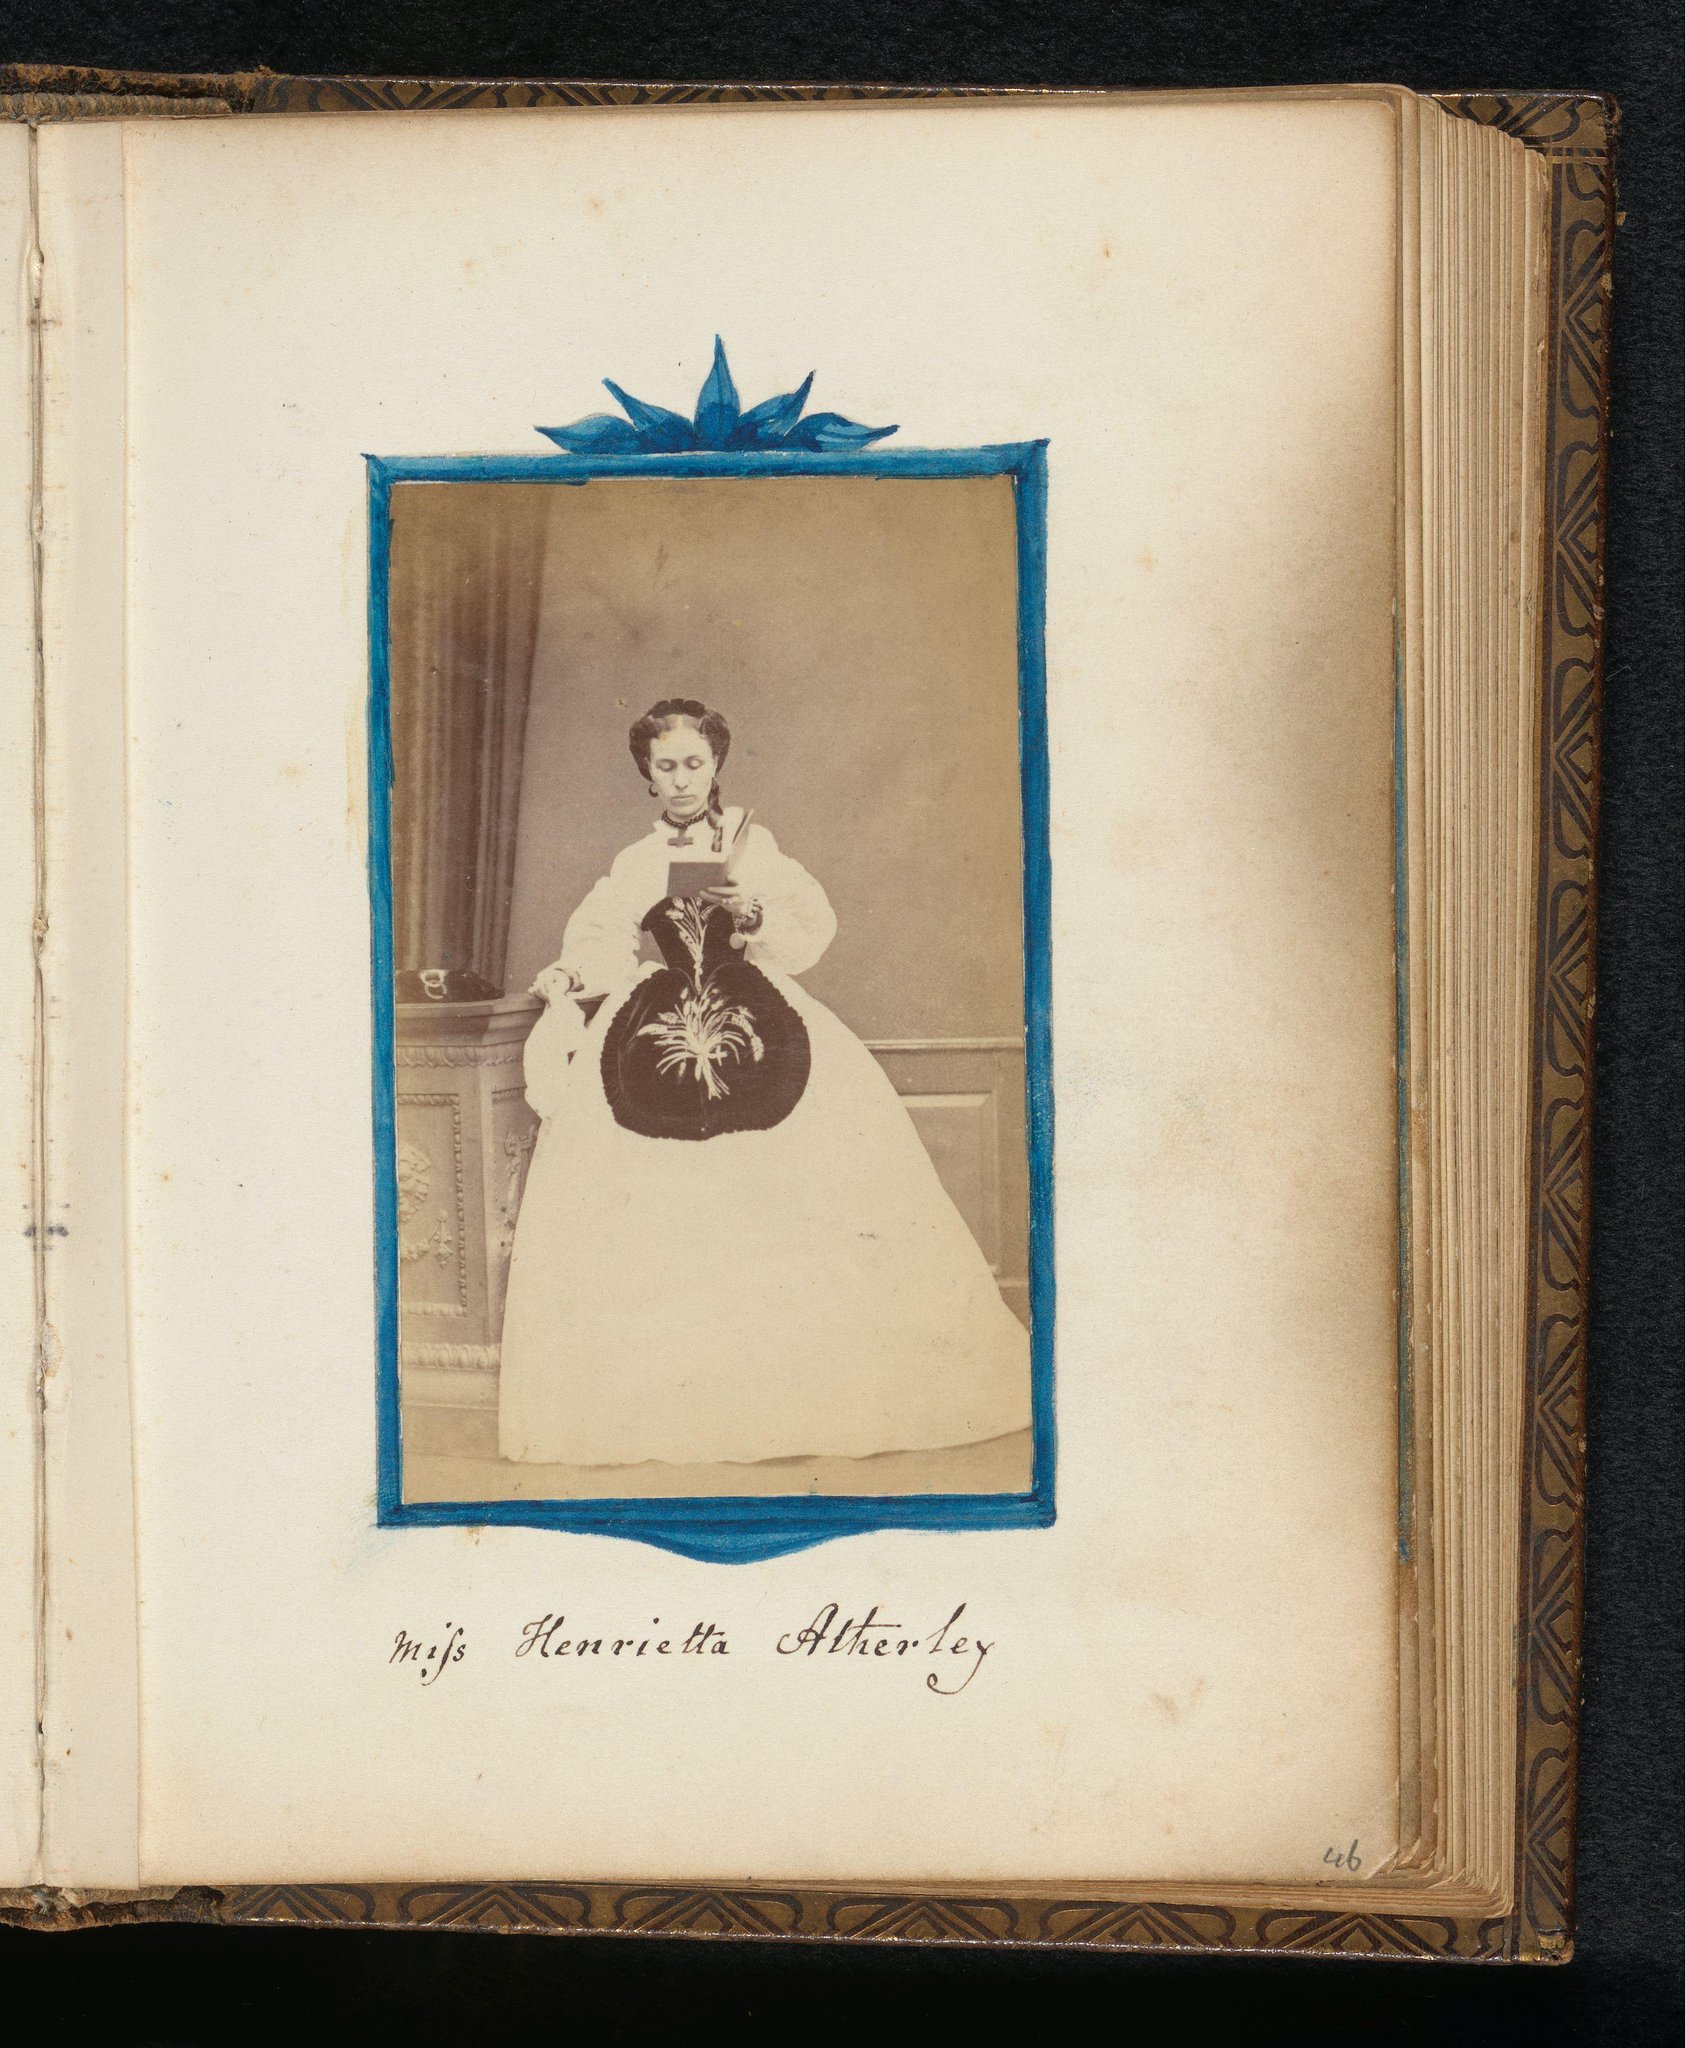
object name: photograph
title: Portret van Miss Henrietta Atherley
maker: Anonymous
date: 1865-1867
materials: cardboard, photographic support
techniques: albumen print, aquarelle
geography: england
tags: historical persons - bb - woman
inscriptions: annotation: ‘Miss Henrietta Atherley’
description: Portret van een jonge vrouw, mej. Henrietta Atherley. Foto op albumblad in album met 68 foto's merendeels met geaquarelleerde randversieringen. Het zijn voornamelijk portretten op carte-de-visite formaat.